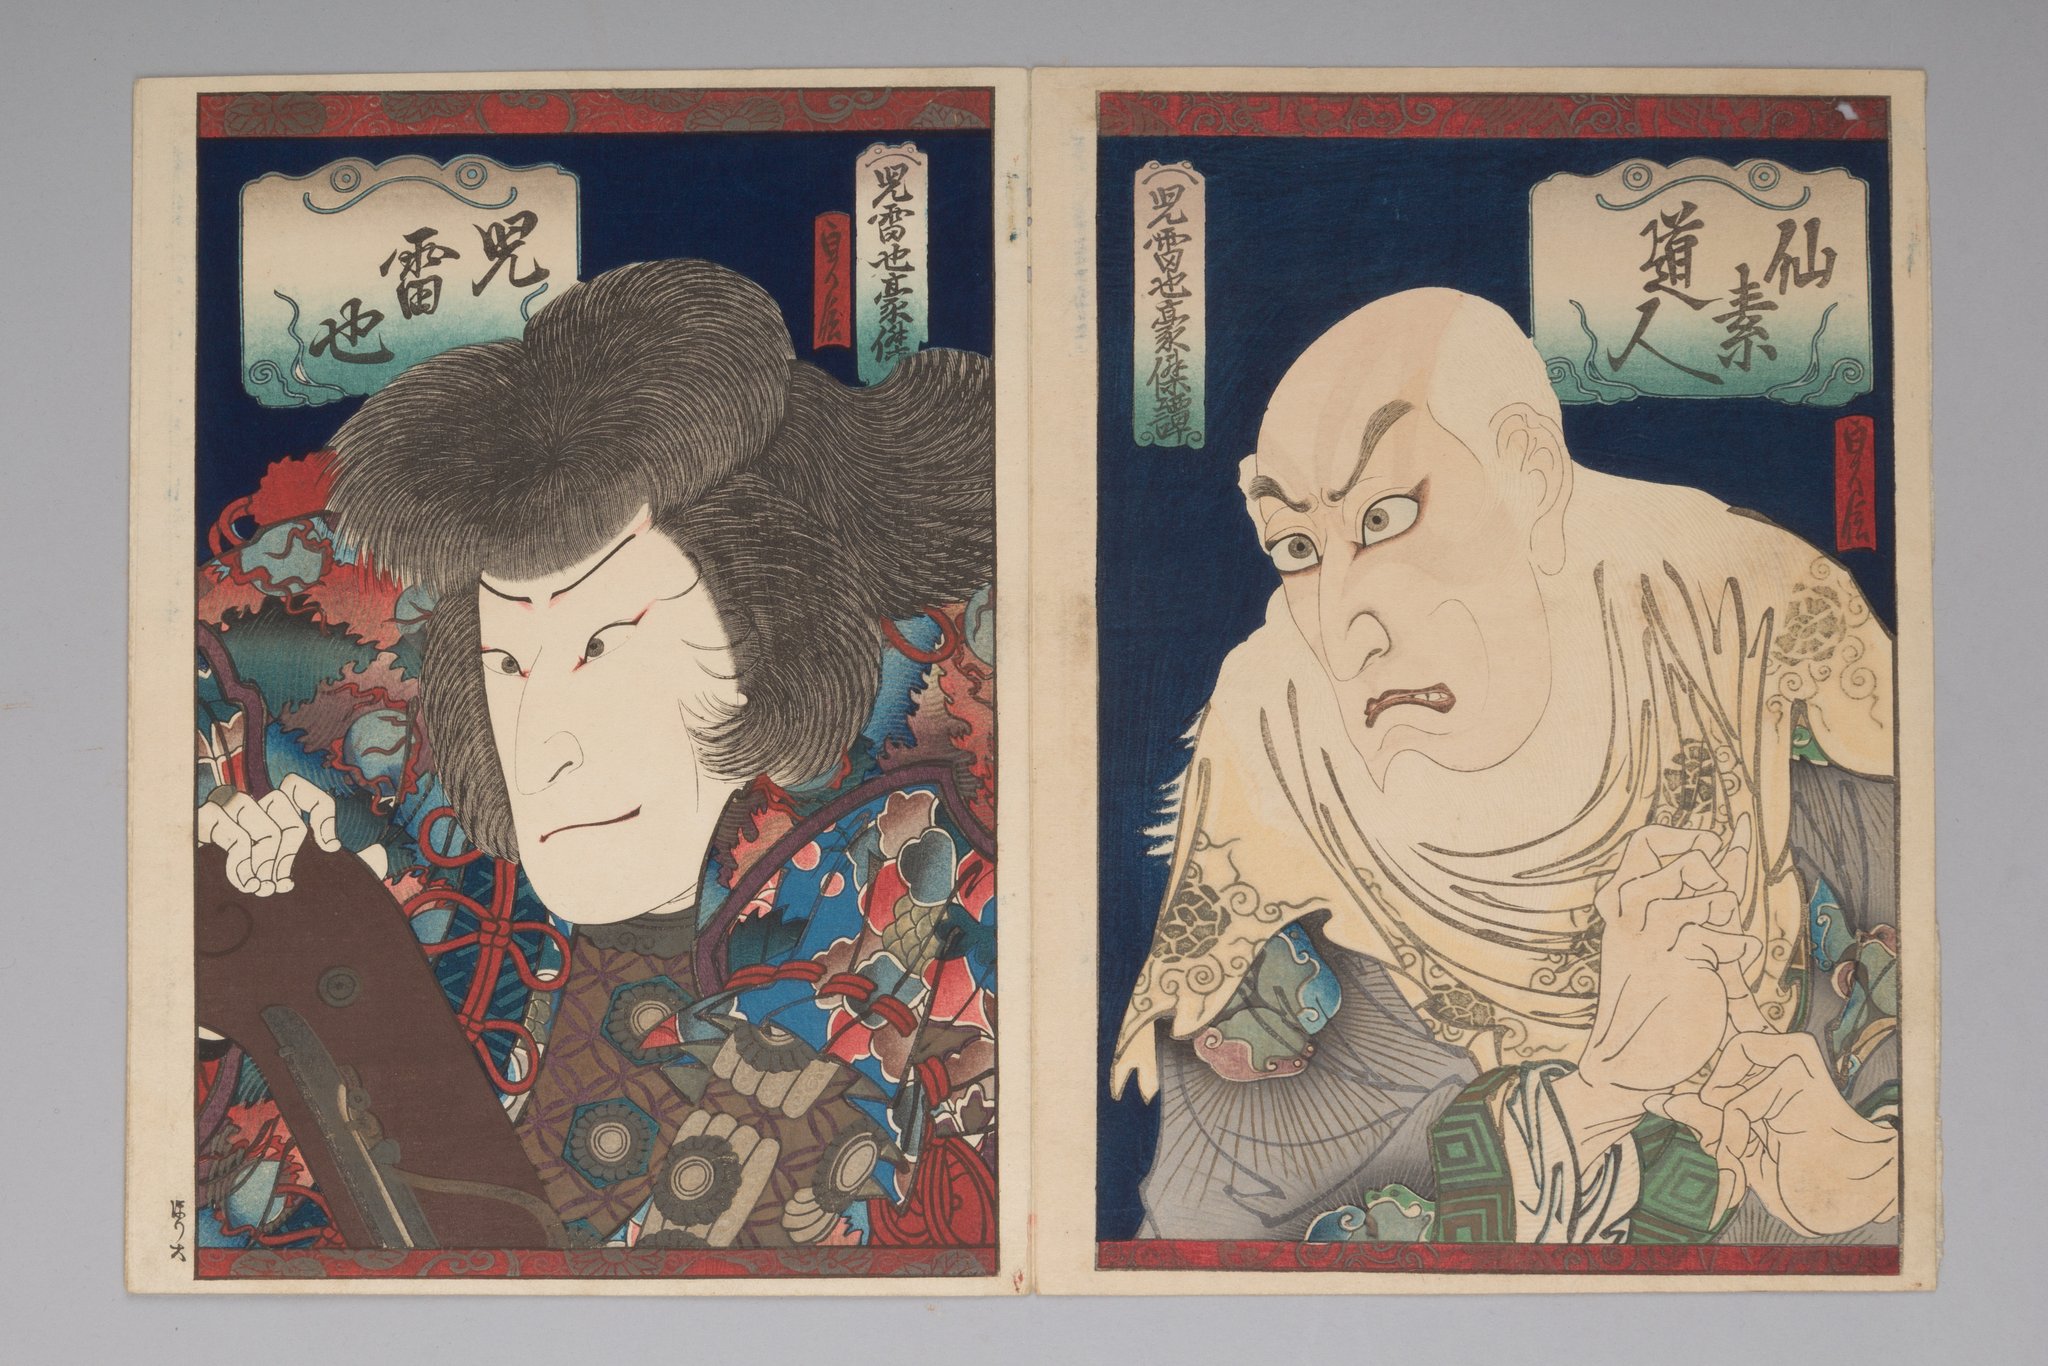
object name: woodblock print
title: Ichikawa Ebizō V as Senso Dōjin (right); Jitsukawa Ensaburō as Jiraiya (left)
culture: japanese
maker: hasegawa sadanobu 長谷川貞信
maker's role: artist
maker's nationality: japanese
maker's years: 1809-1879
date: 1854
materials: ink, paper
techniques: woodblock print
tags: men,actors